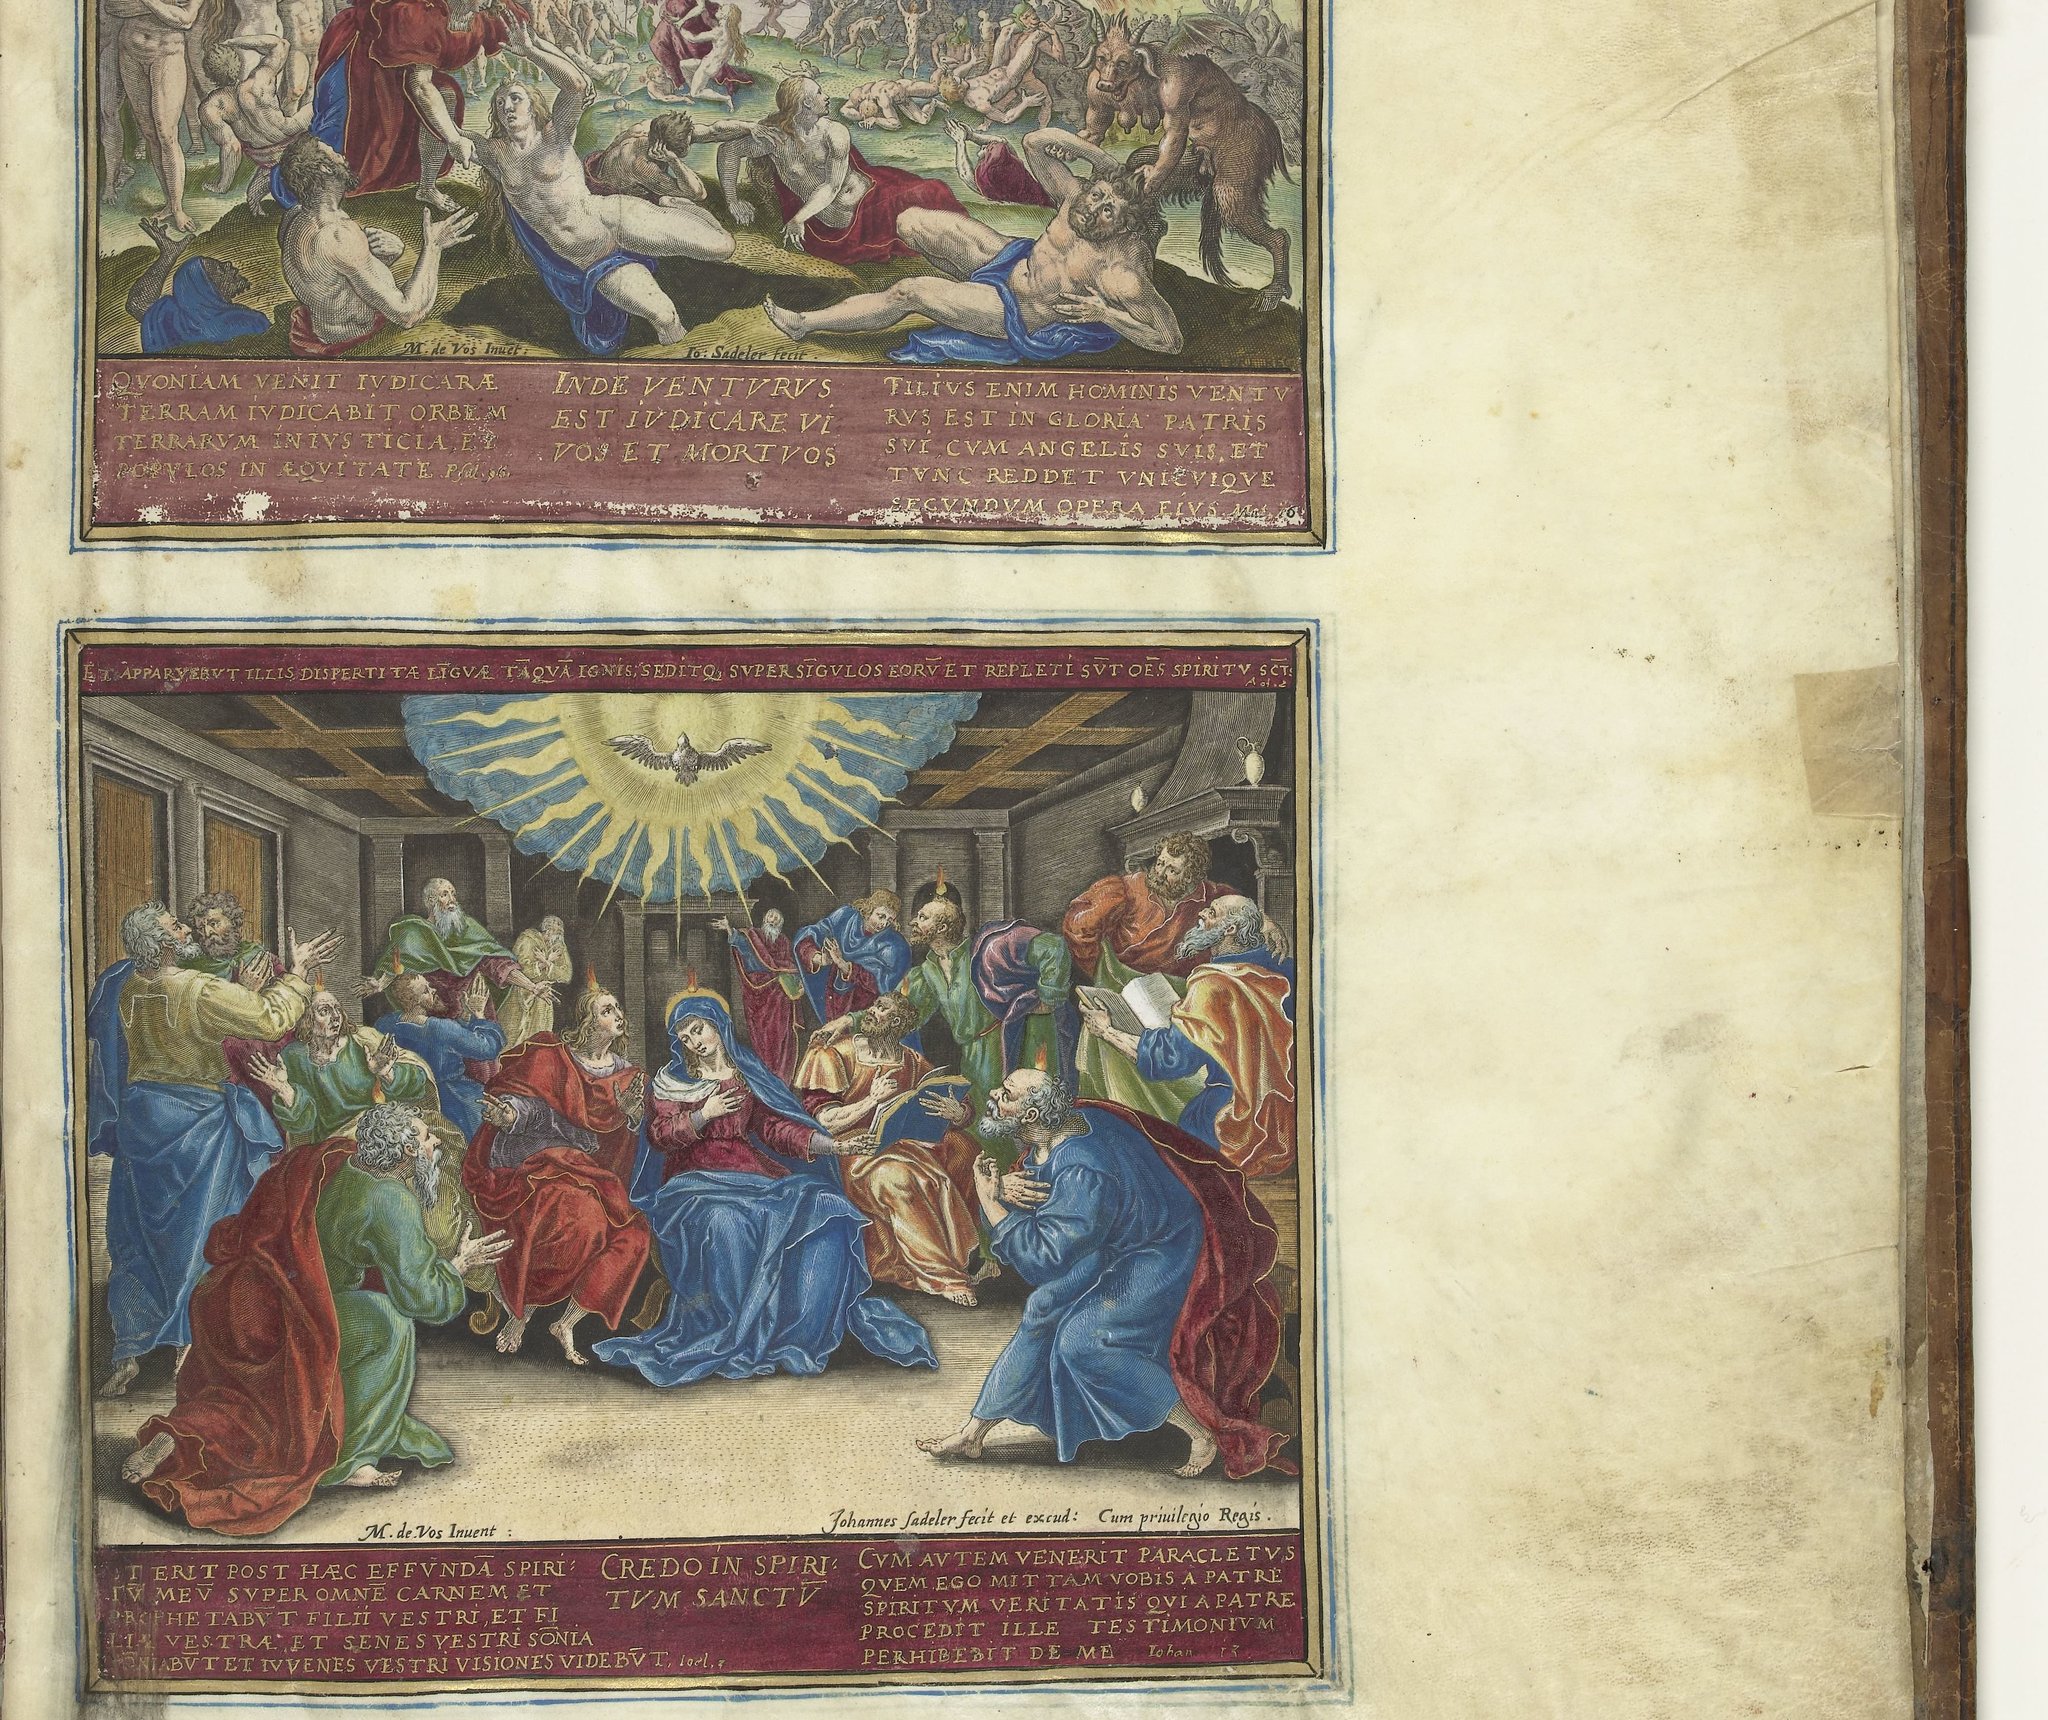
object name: album leaf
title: Credo in Spiritum Sanctu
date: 1579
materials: paper, parchment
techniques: engraving, hand coloring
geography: cologne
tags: 'credo in spiritum sanctum' ~ articles of faith, pentecost: the holy ghost descends upon (mary and) the apostles, sometimes paul and/or representatives of the nations present (acts 2:1-4)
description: Illustratie van het achtste geloofsartikel (Ik geloof in de heilige Geest) van de apostolische geloofsbelijdenis. Maria en de twaalf apostelen zitten in een kamervertrek. Vurige tongen branden boven de hoofden van enkele van hen. De Heilige Geest, in de gedaante van een duif, zweeft boven de apostelen, omgeven door lichtstralen. Boven de voorstelling een verwijzing naar de Bijbeltekst in Hand. 2:3-4. Onder de voorstelling twee Bijbelteksten en het achtste geloofsartikel uit de apostolische geloofsbelijdenis in het Latijn. Deze prent maakt deel uit van een album.